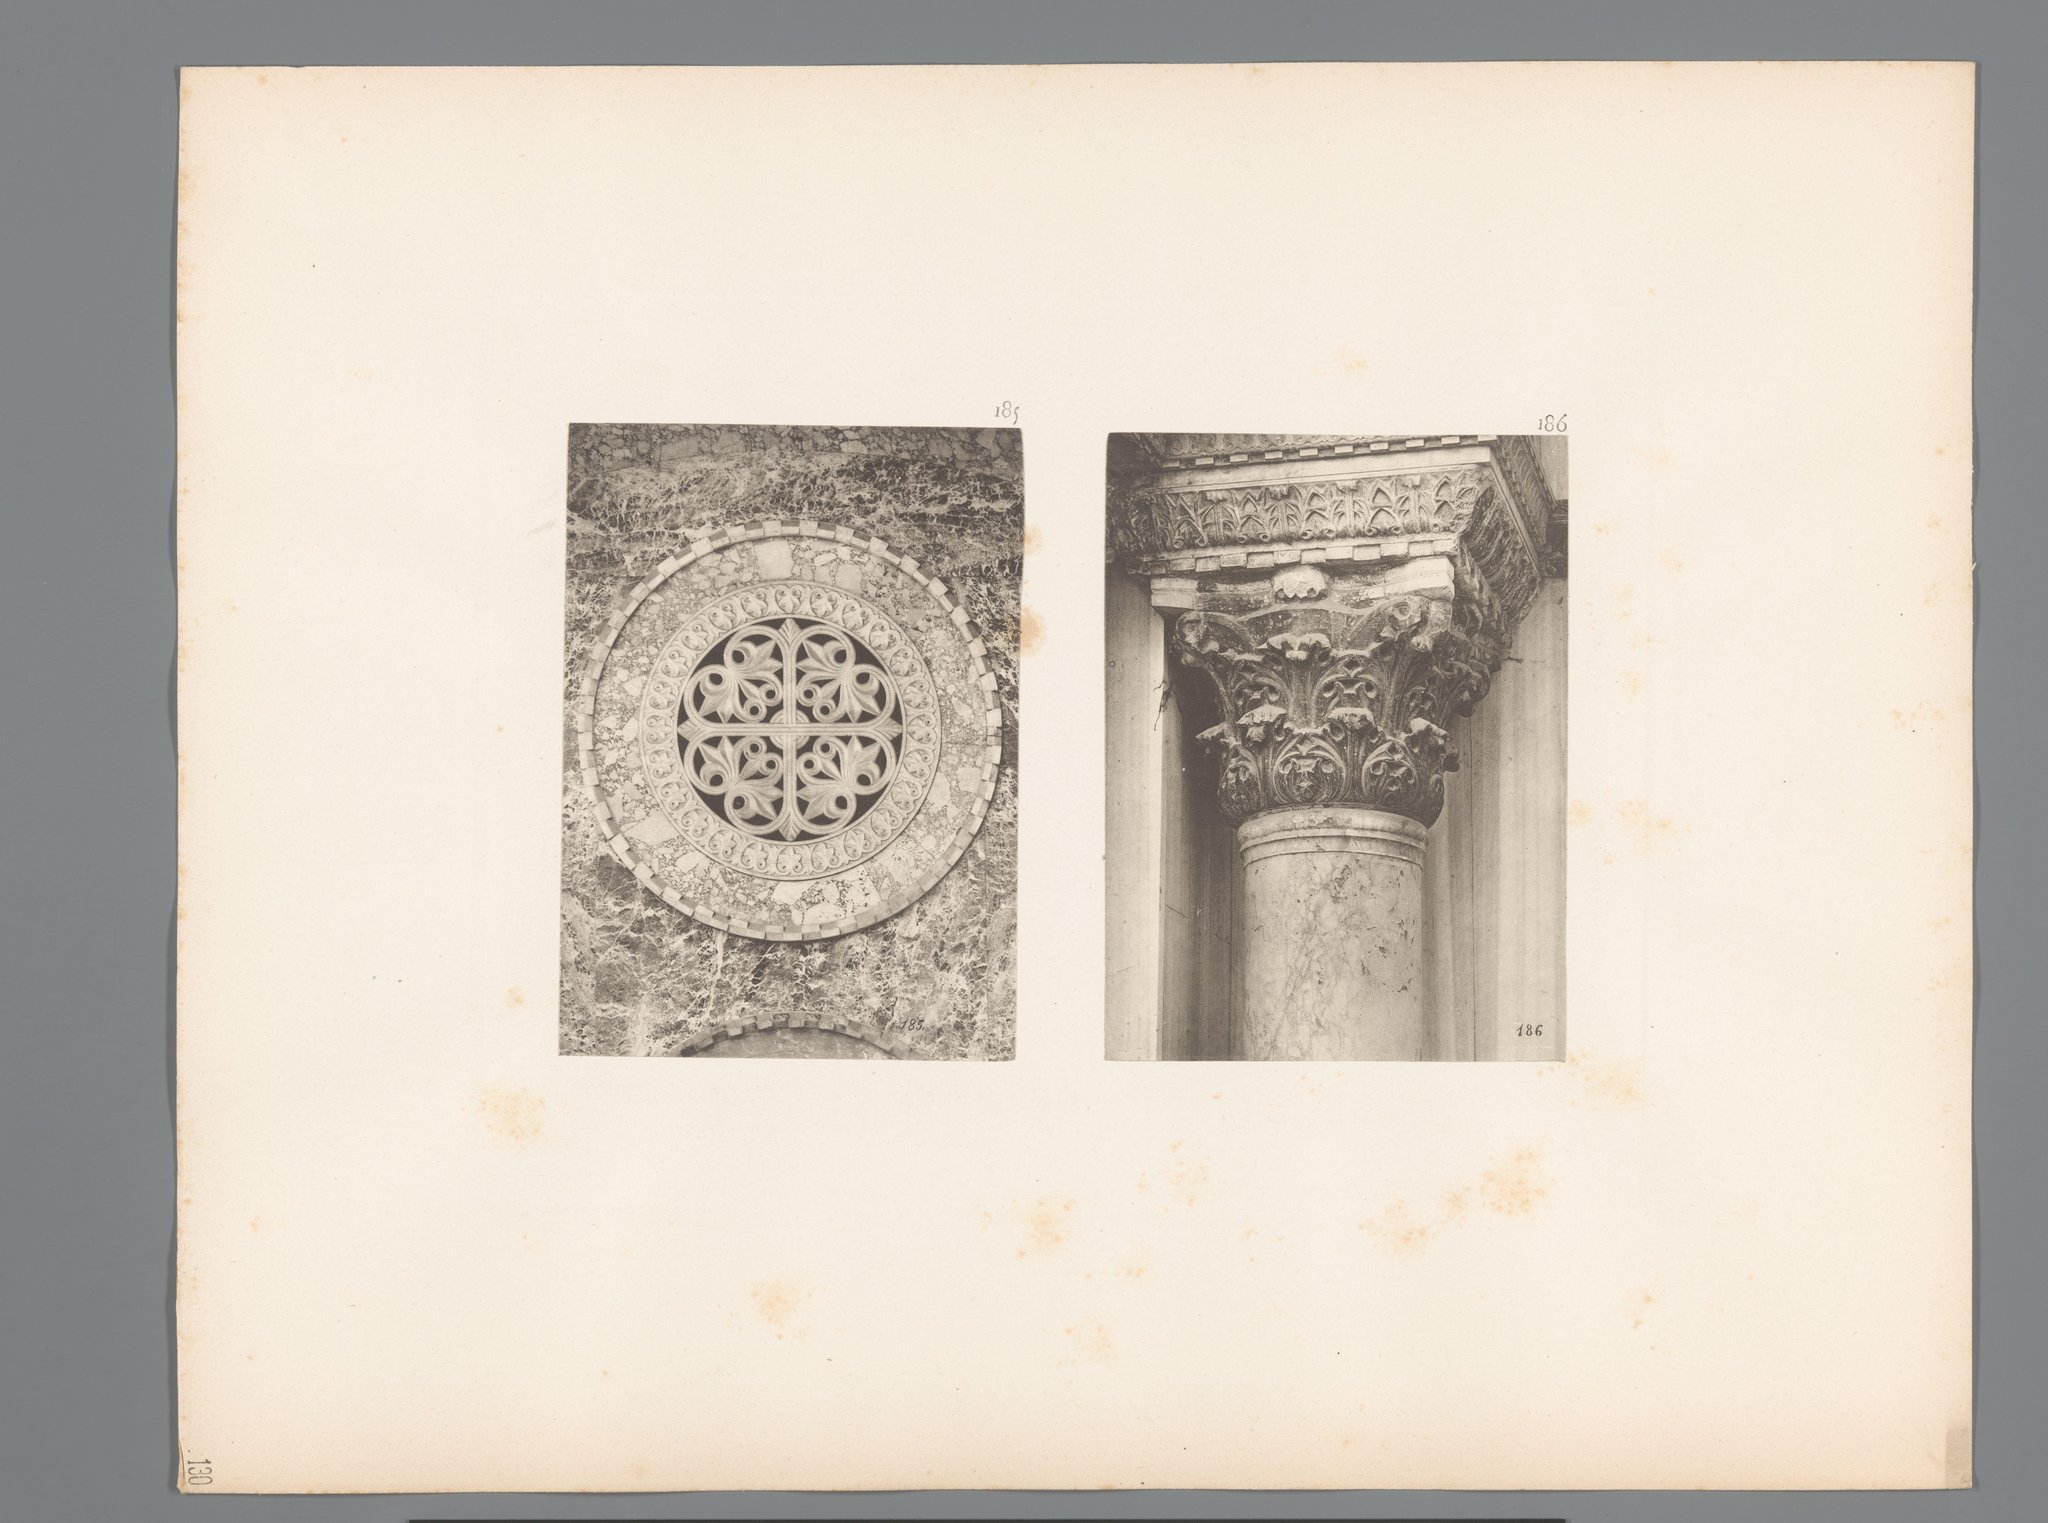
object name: photomechanical print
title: Deel van het exterieur en een Korinthisch kapiteel van de San Marco in Venetië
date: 1879-1884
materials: paper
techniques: photograph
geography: venice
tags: capital (~ column, pillar) (+ classical art), church (exterior), corinthian order ~ architecture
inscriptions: number: ‘186’, number: ‘185.’, number: ‘186’, number: ‘130’, number: ‘185’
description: Deze prenten maken deel uit van een omslag met 51 prenten op 29 bladen en 1 tekstblad.